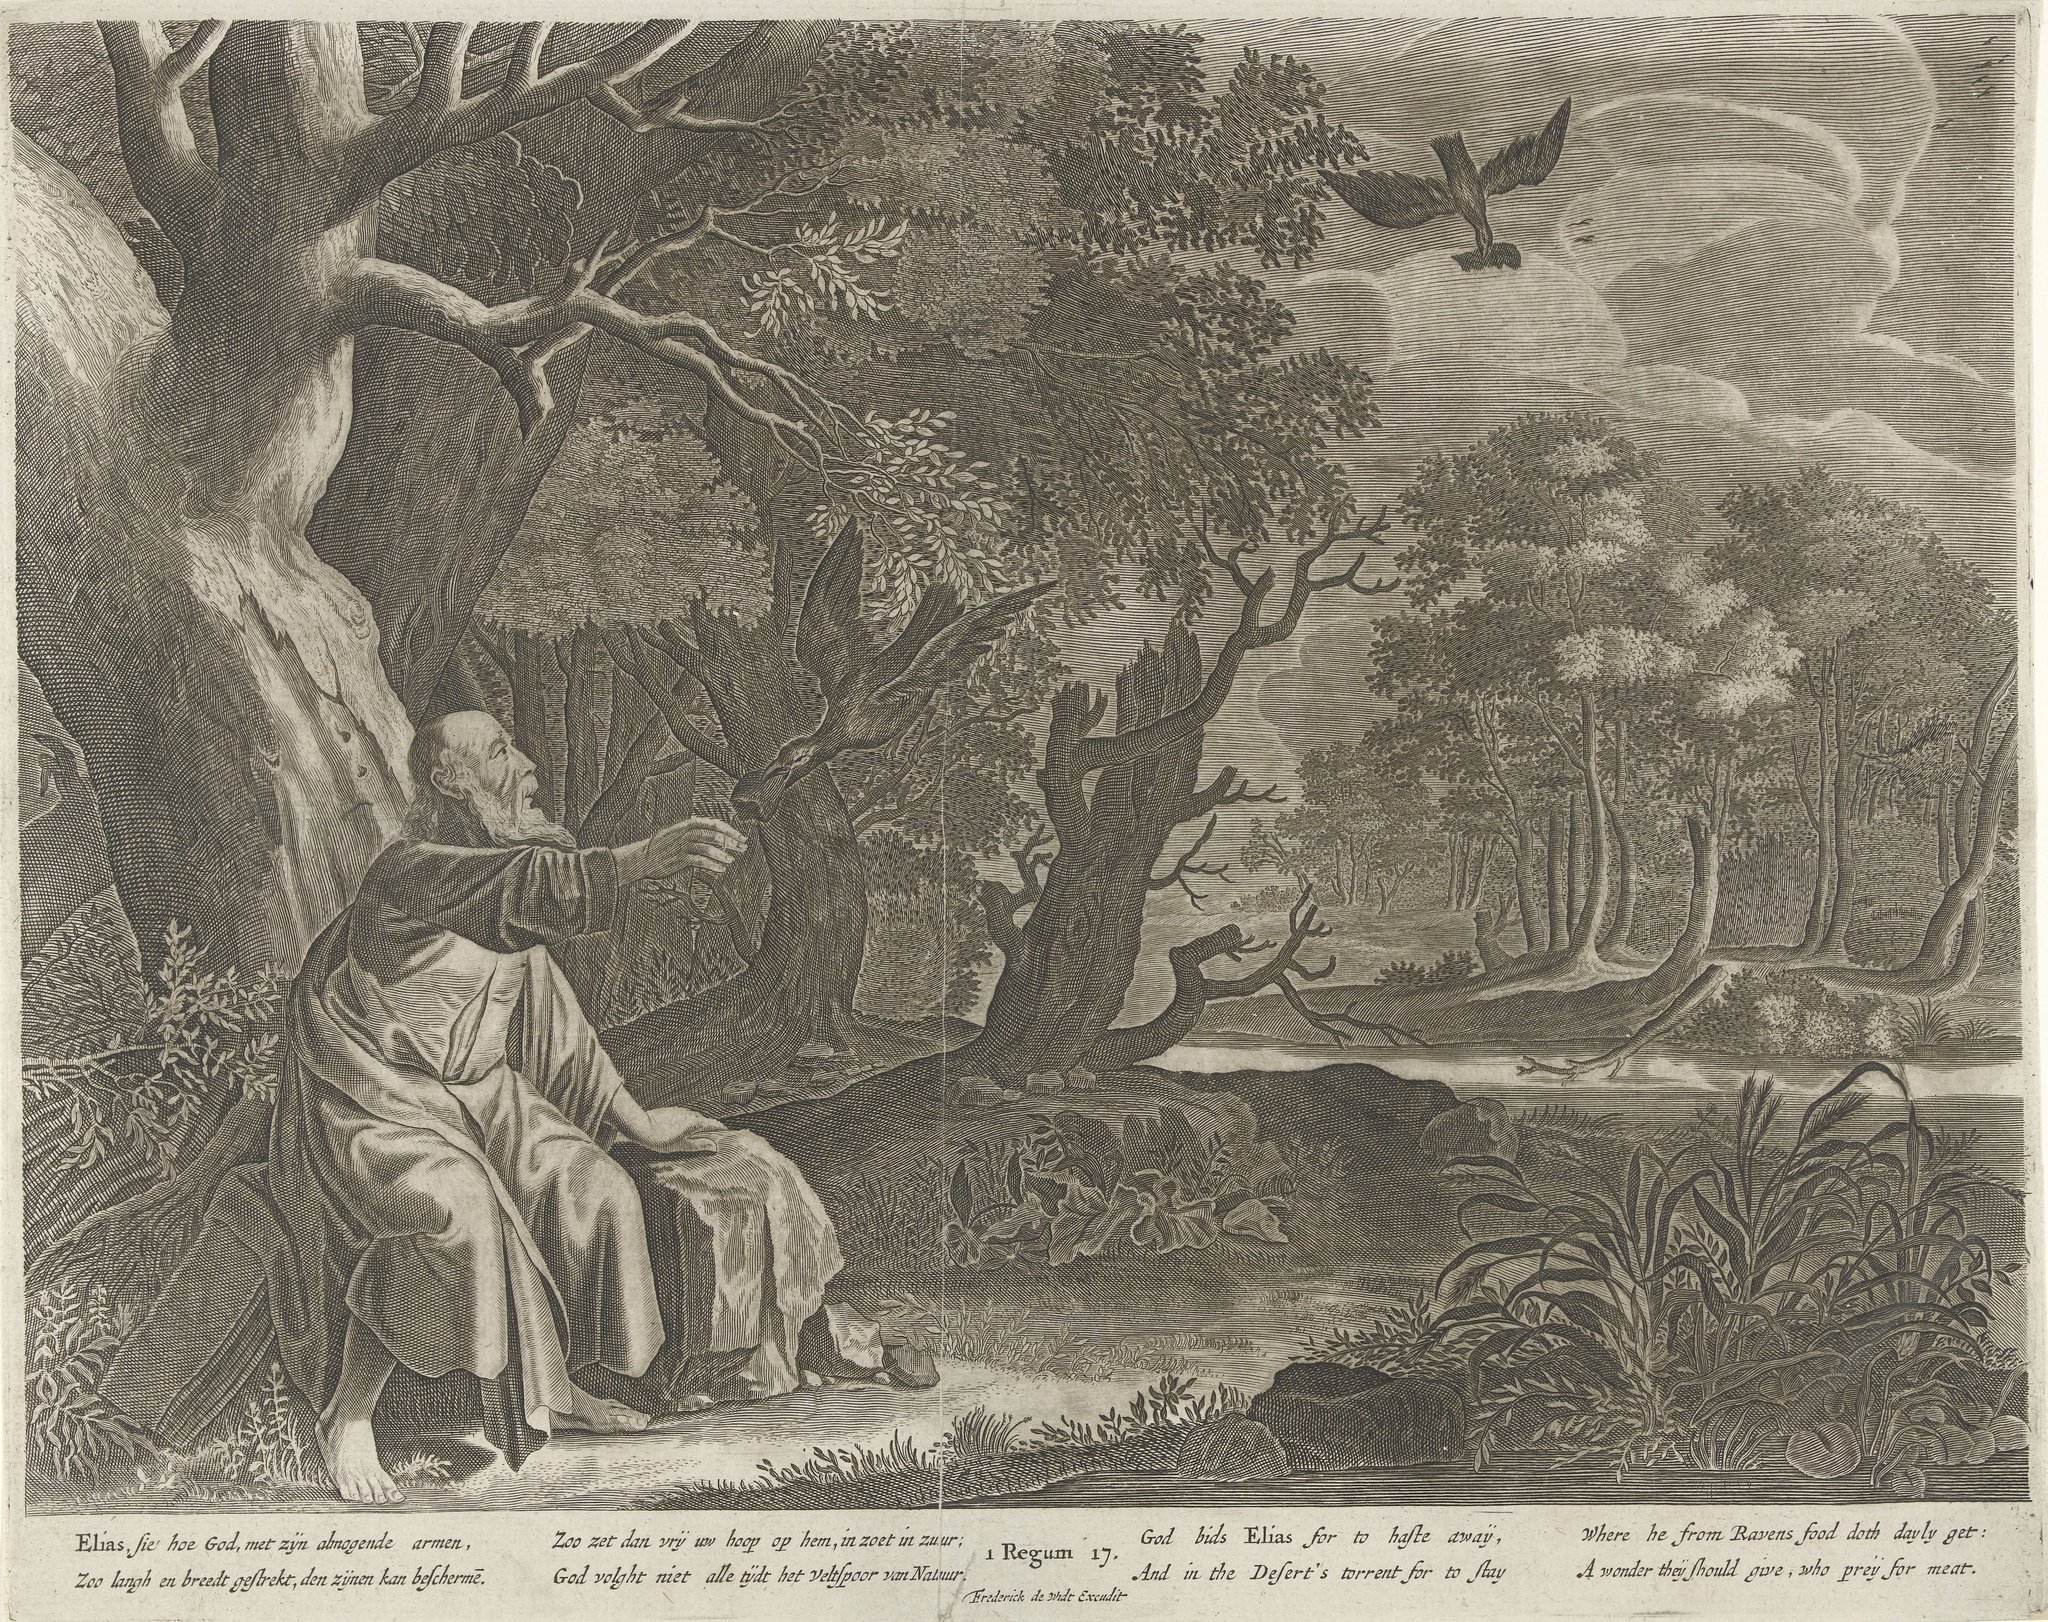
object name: print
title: Elia gevoed door de raven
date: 1645-1706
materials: paper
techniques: engraving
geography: amsterdam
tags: elijah fed by the raven(s): while the prophet is living by the brook, ravens bring him food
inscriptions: collector's mark: Lugt 2228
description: Elia zit links onder een boom aan een rivier, waar de raven hem brood en vlees komen brengen. Naast hem ligt een groot boek. Naar de Bijbeltekst in 1 Kon. 17:6. Onderaan in de marge vier tweeregelige teksten in het Nederlands en Engels.